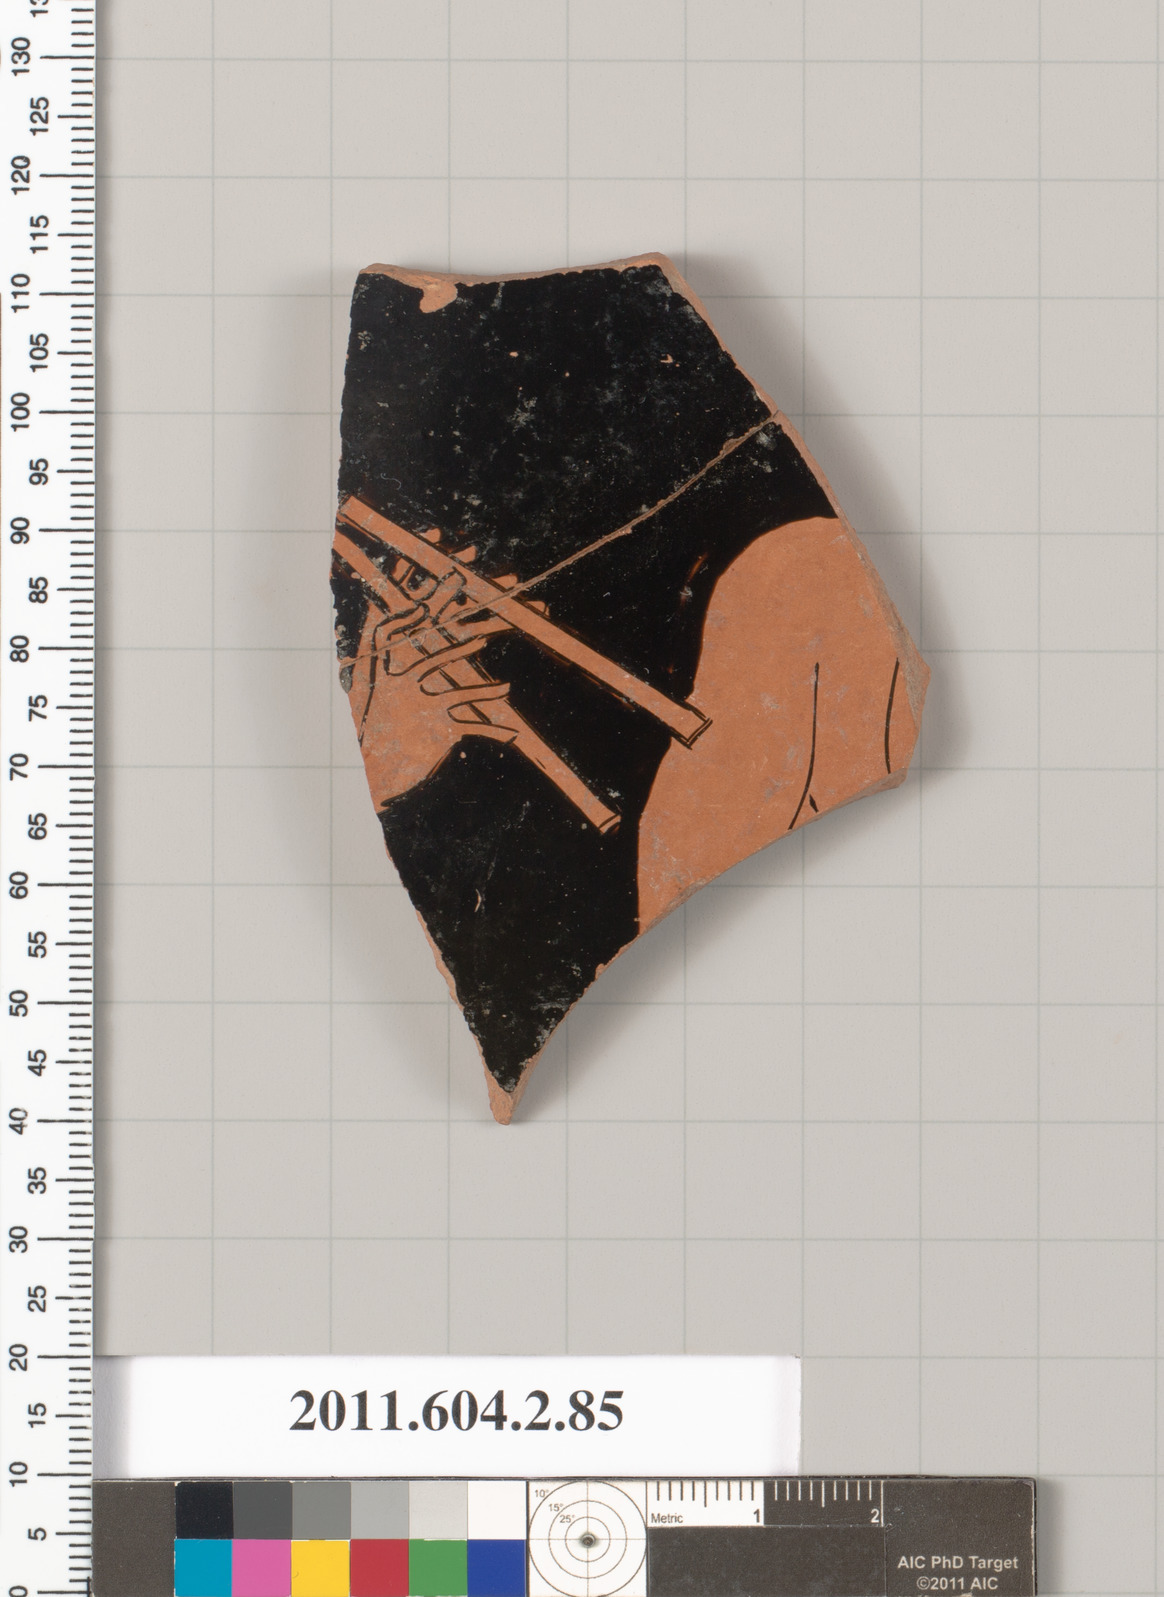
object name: pelike fragment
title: Terracotta fragment of a pelike (jar)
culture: greek, attic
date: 490-480 BCE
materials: terracotta